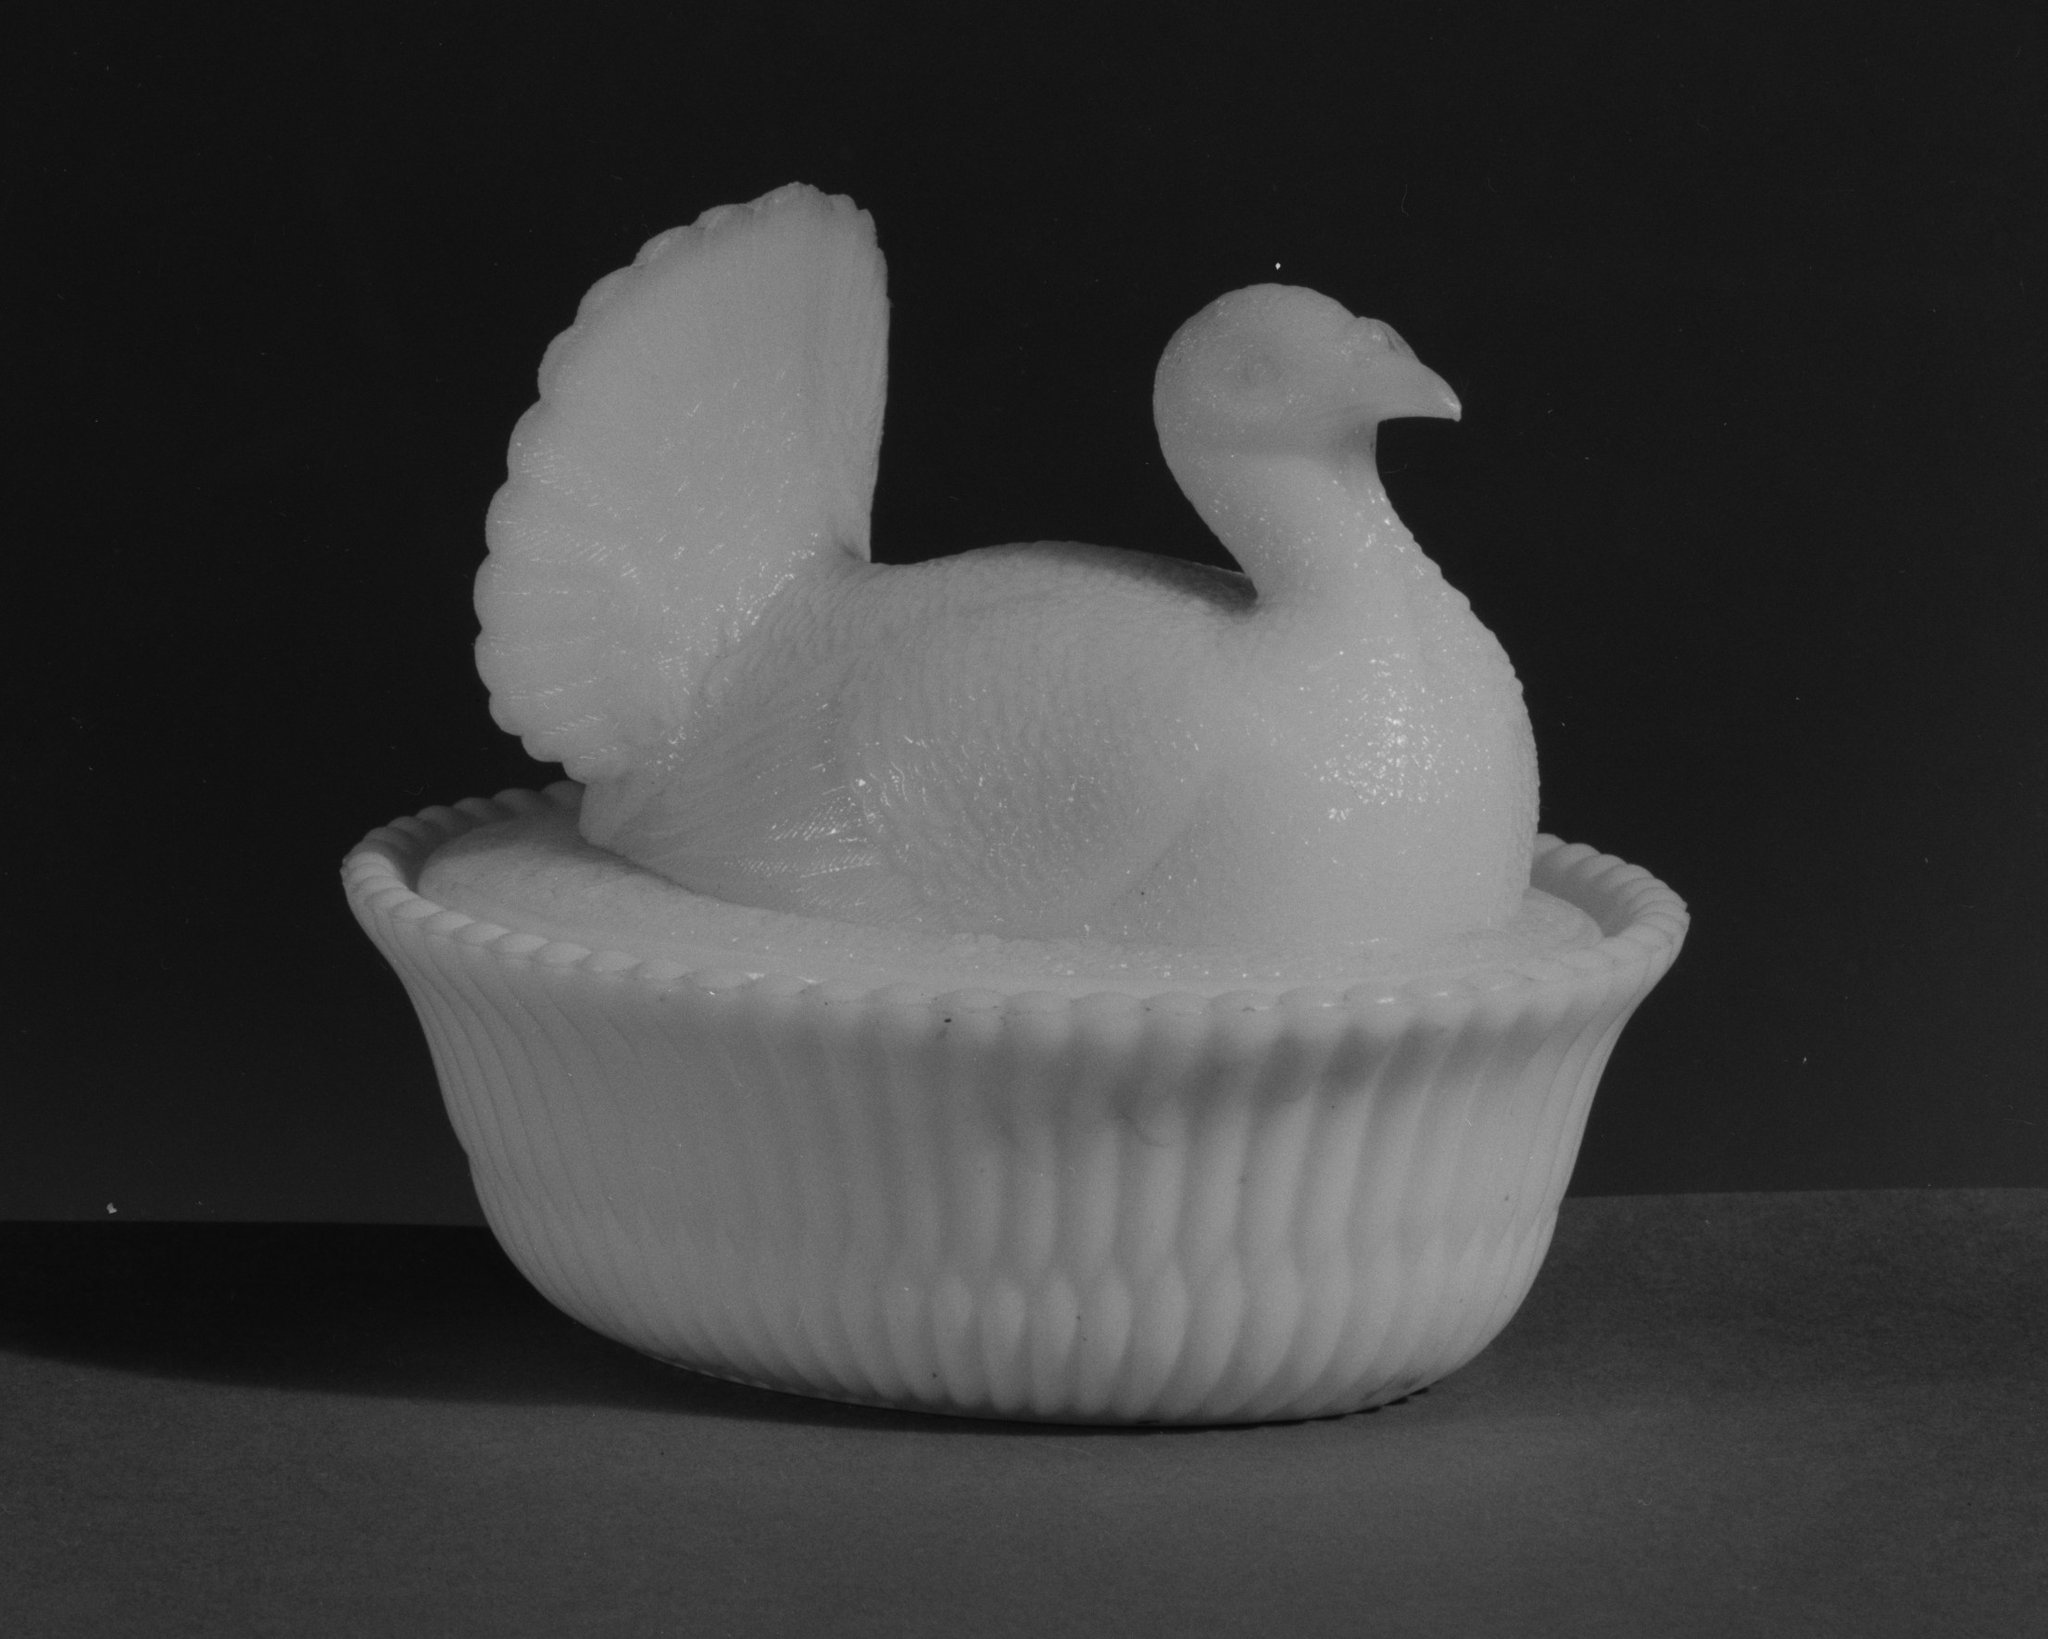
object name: dish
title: Figure Dish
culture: american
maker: mckee and brothers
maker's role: maker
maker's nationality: american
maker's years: 1856-1889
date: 1880-1890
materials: glass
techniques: pressed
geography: united states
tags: turkeys